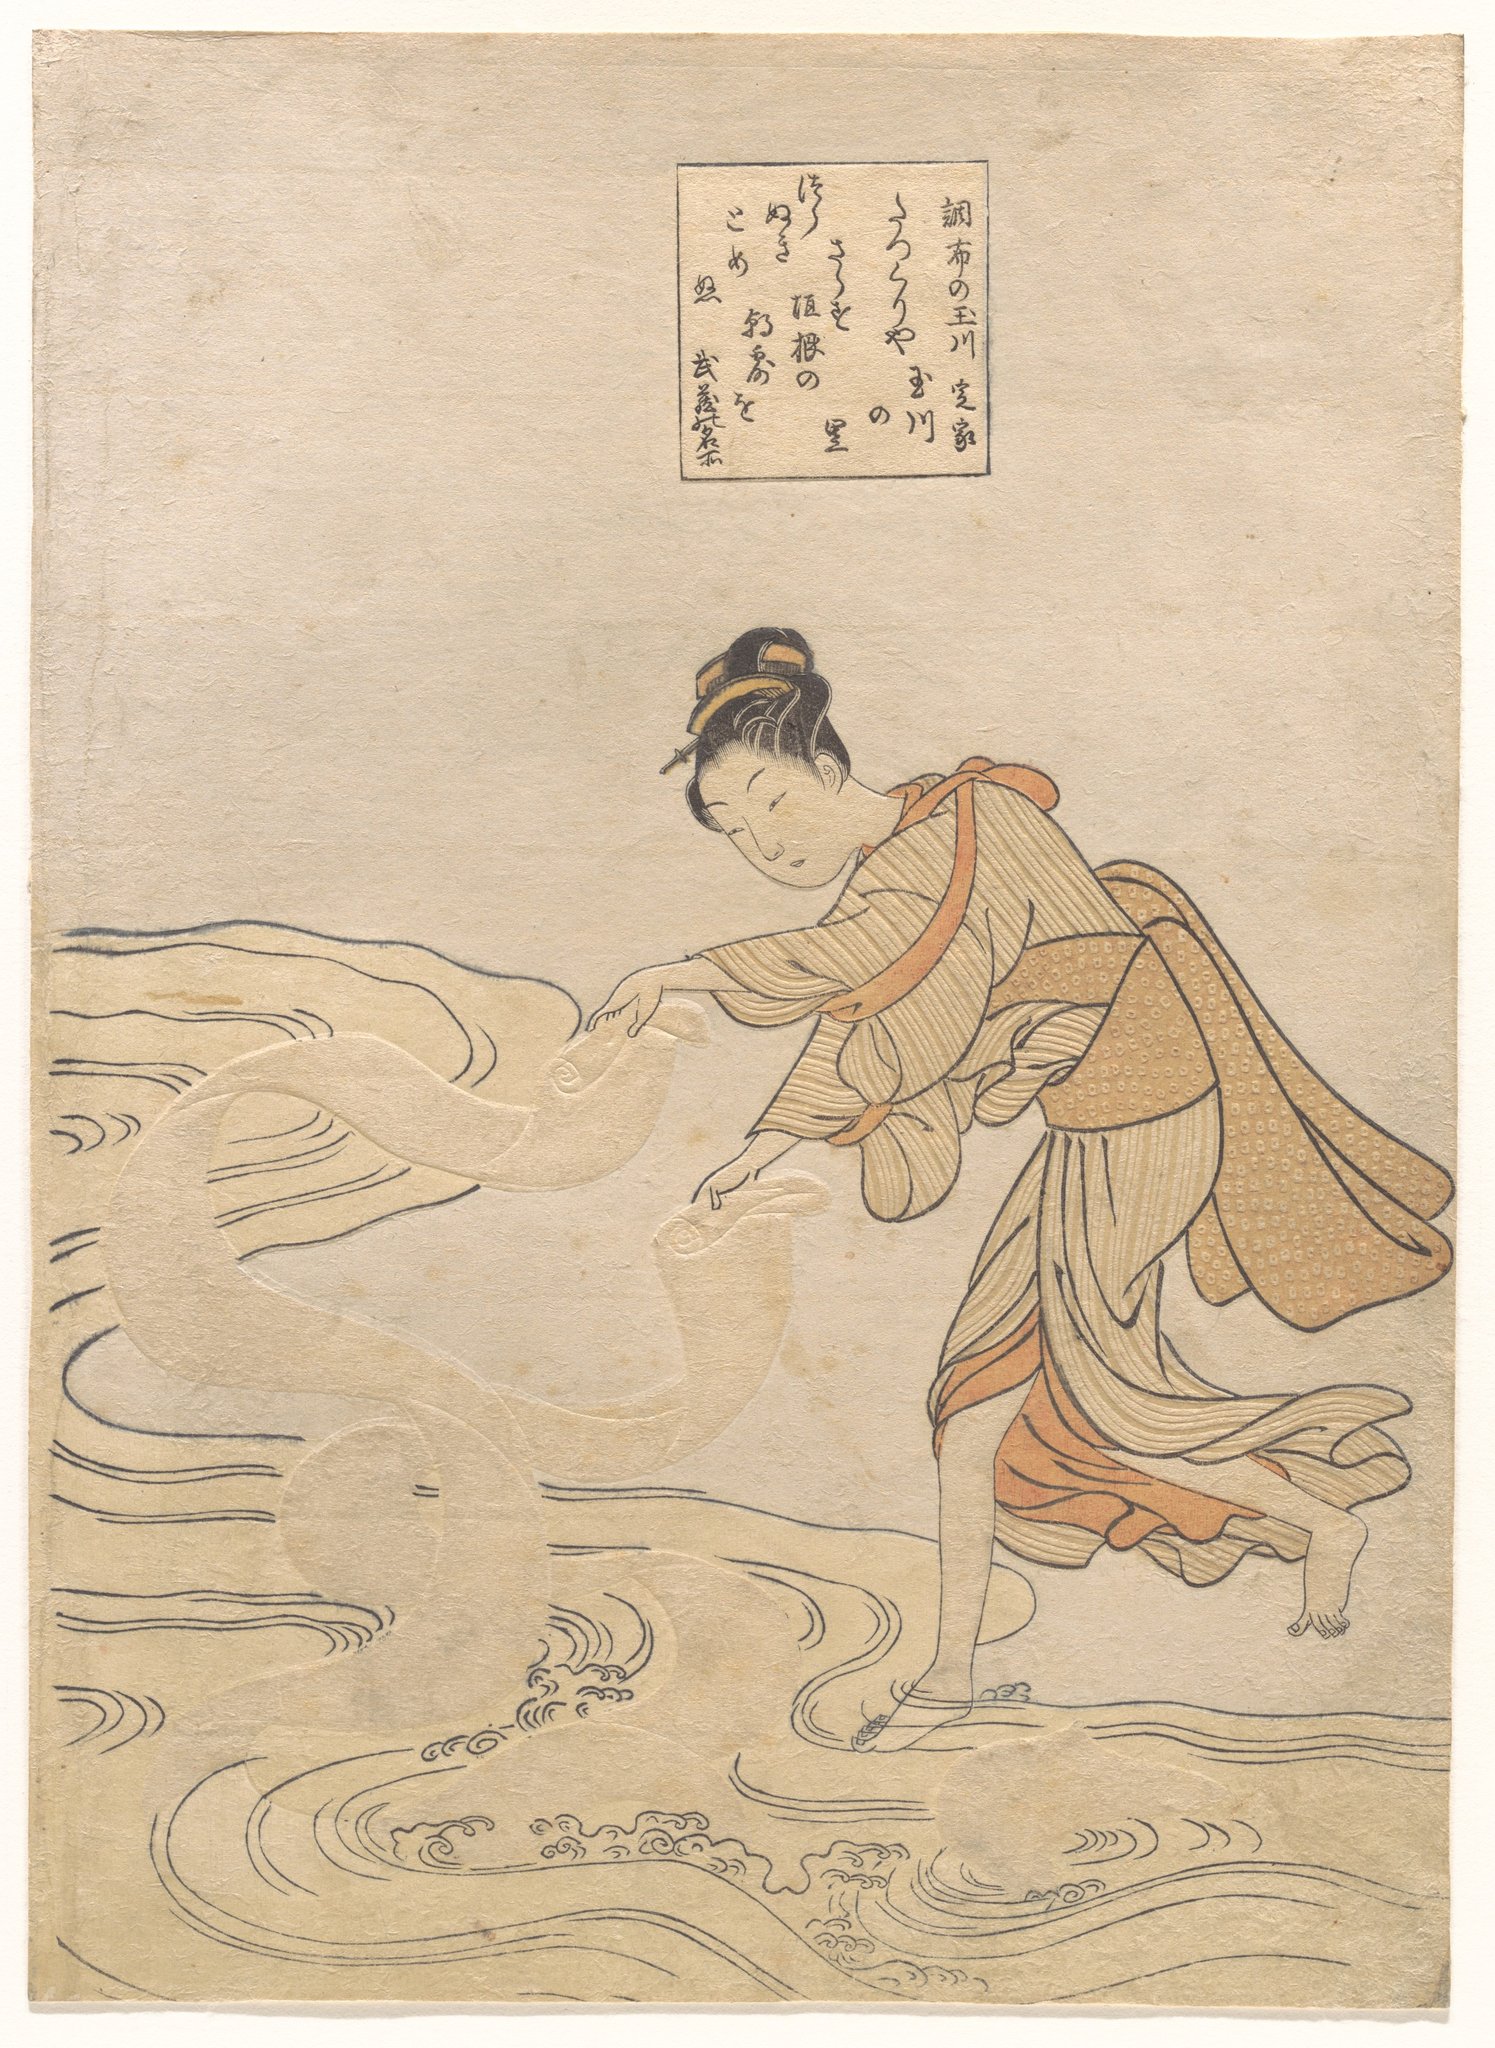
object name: print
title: The Jewel River at Chōfu (Chōfu no Tamagawa)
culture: japanese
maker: suzuki harunobu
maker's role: artist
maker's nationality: japanese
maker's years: 1725-1770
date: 1768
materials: ink, paper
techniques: woodblock print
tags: women,rivers